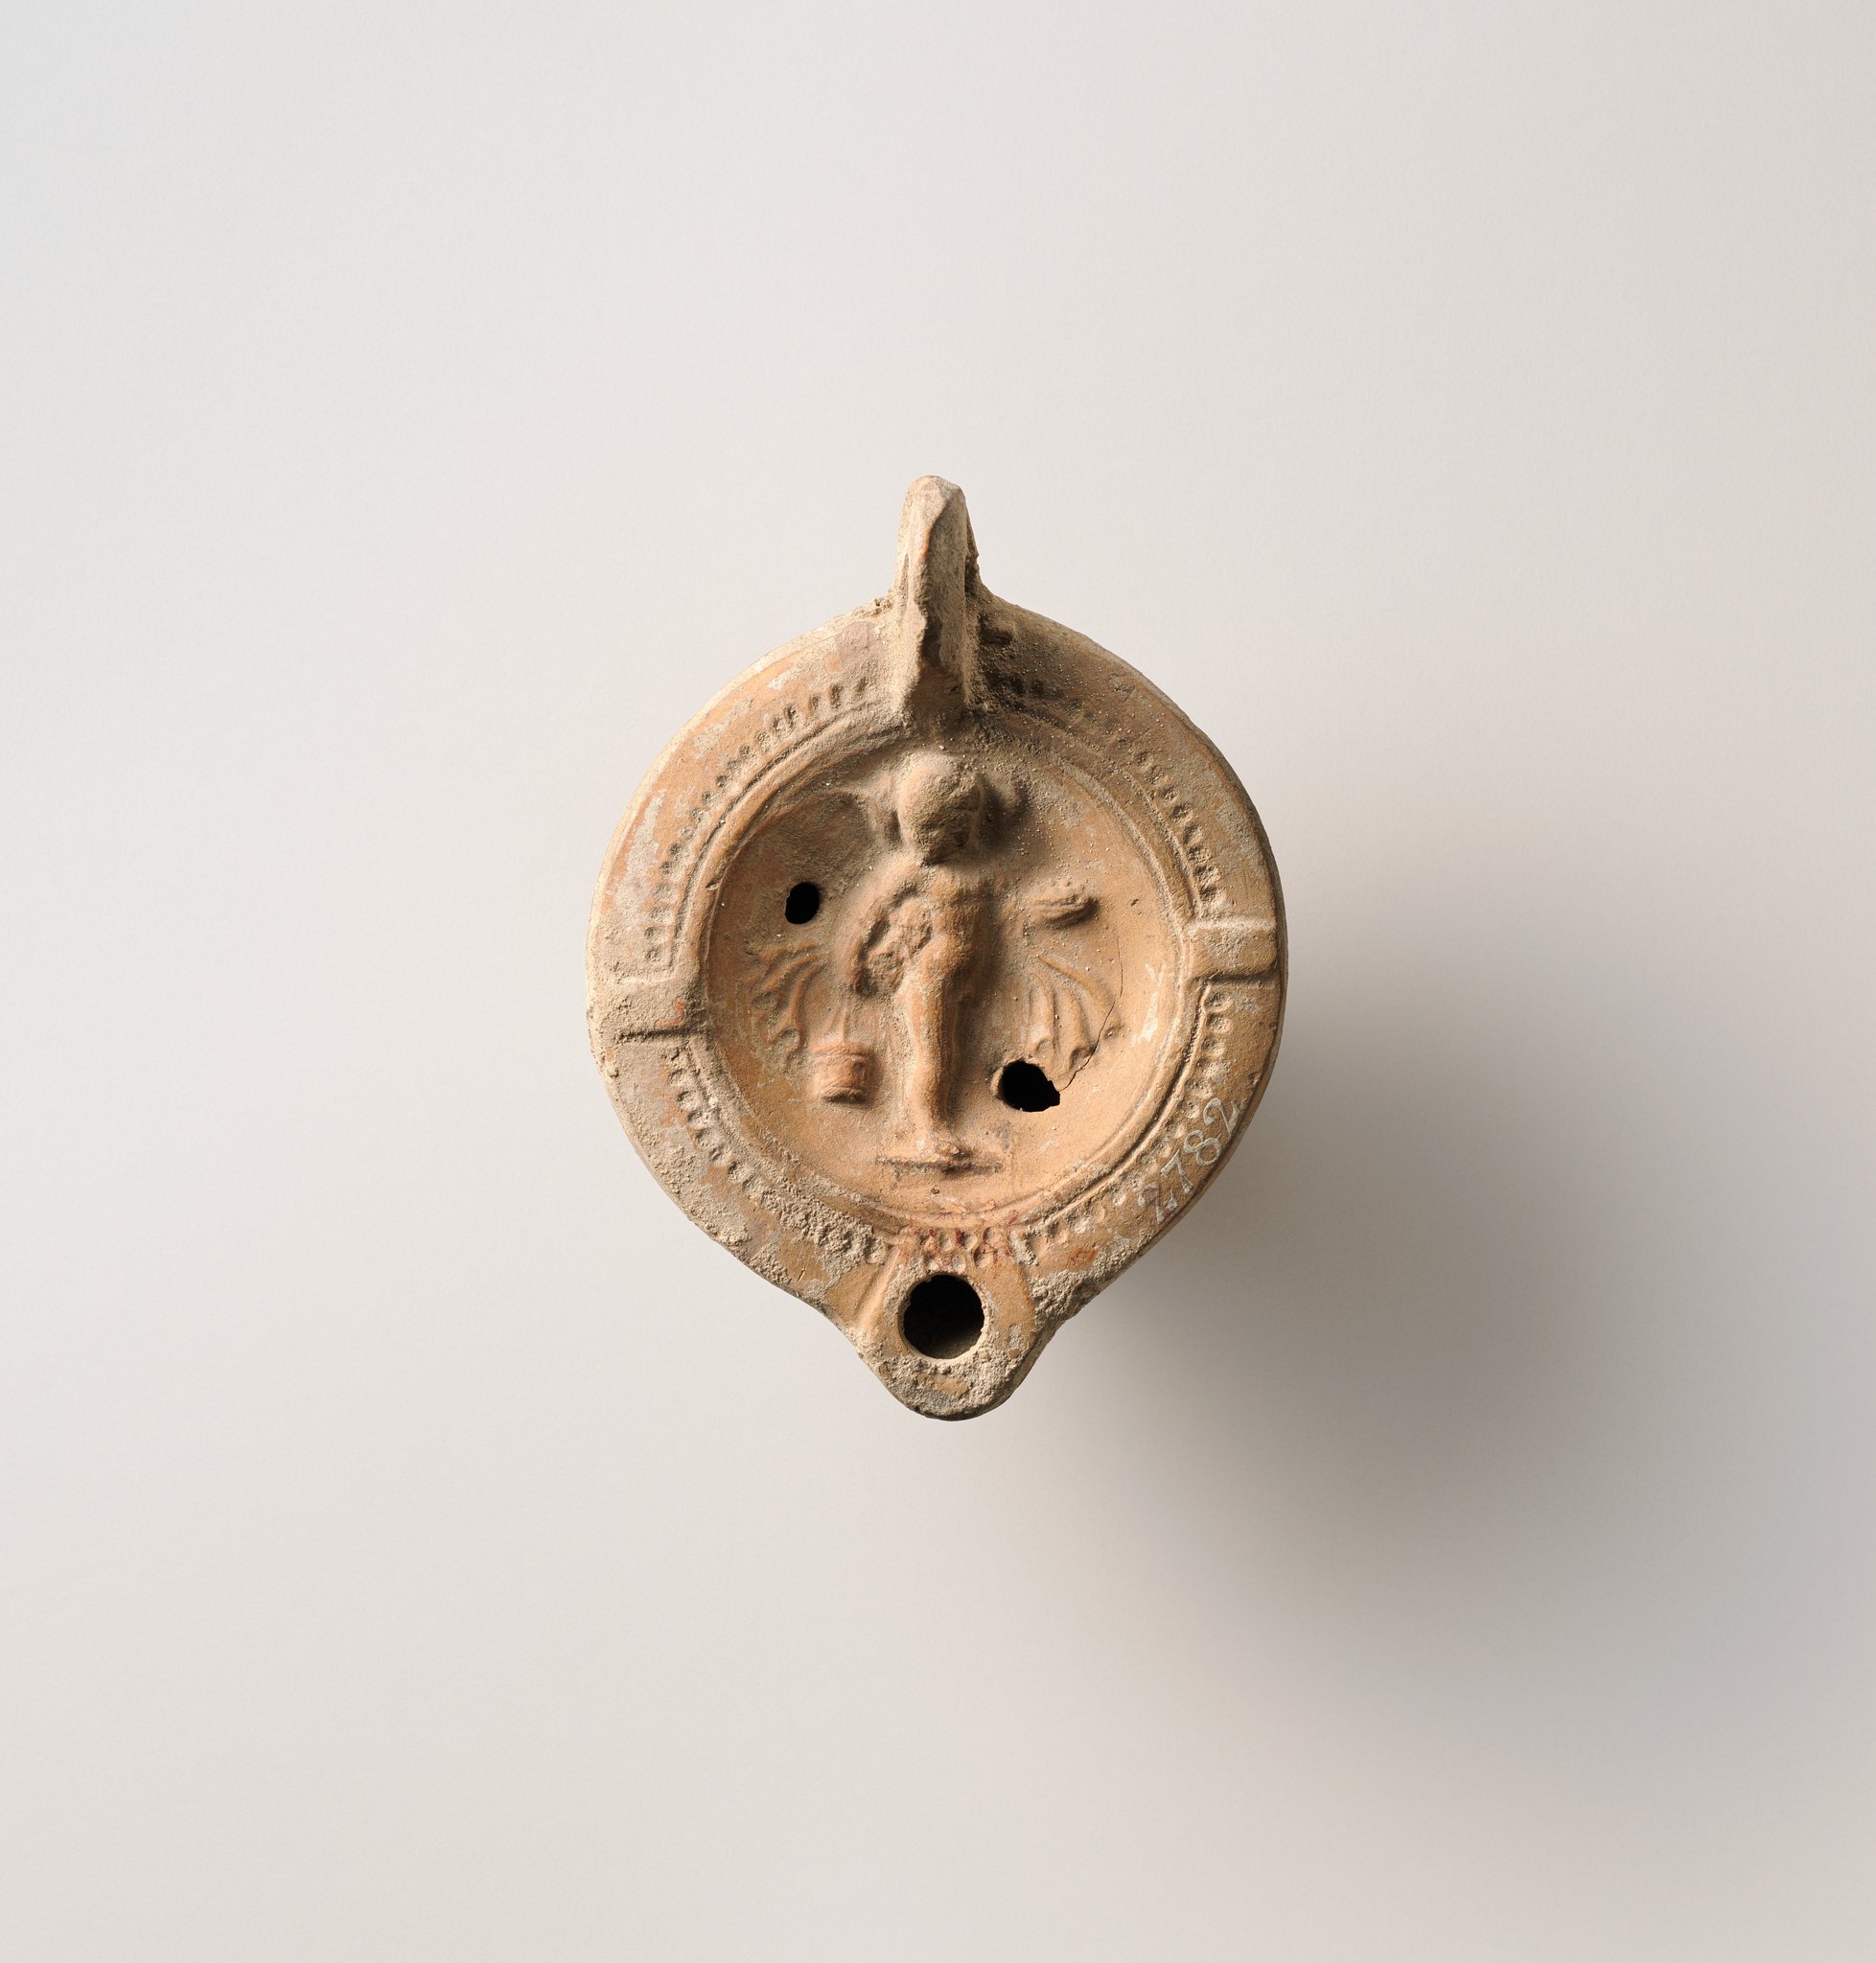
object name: lamp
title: Terracotta oil lamp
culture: roman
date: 175-250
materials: terracotta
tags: eros